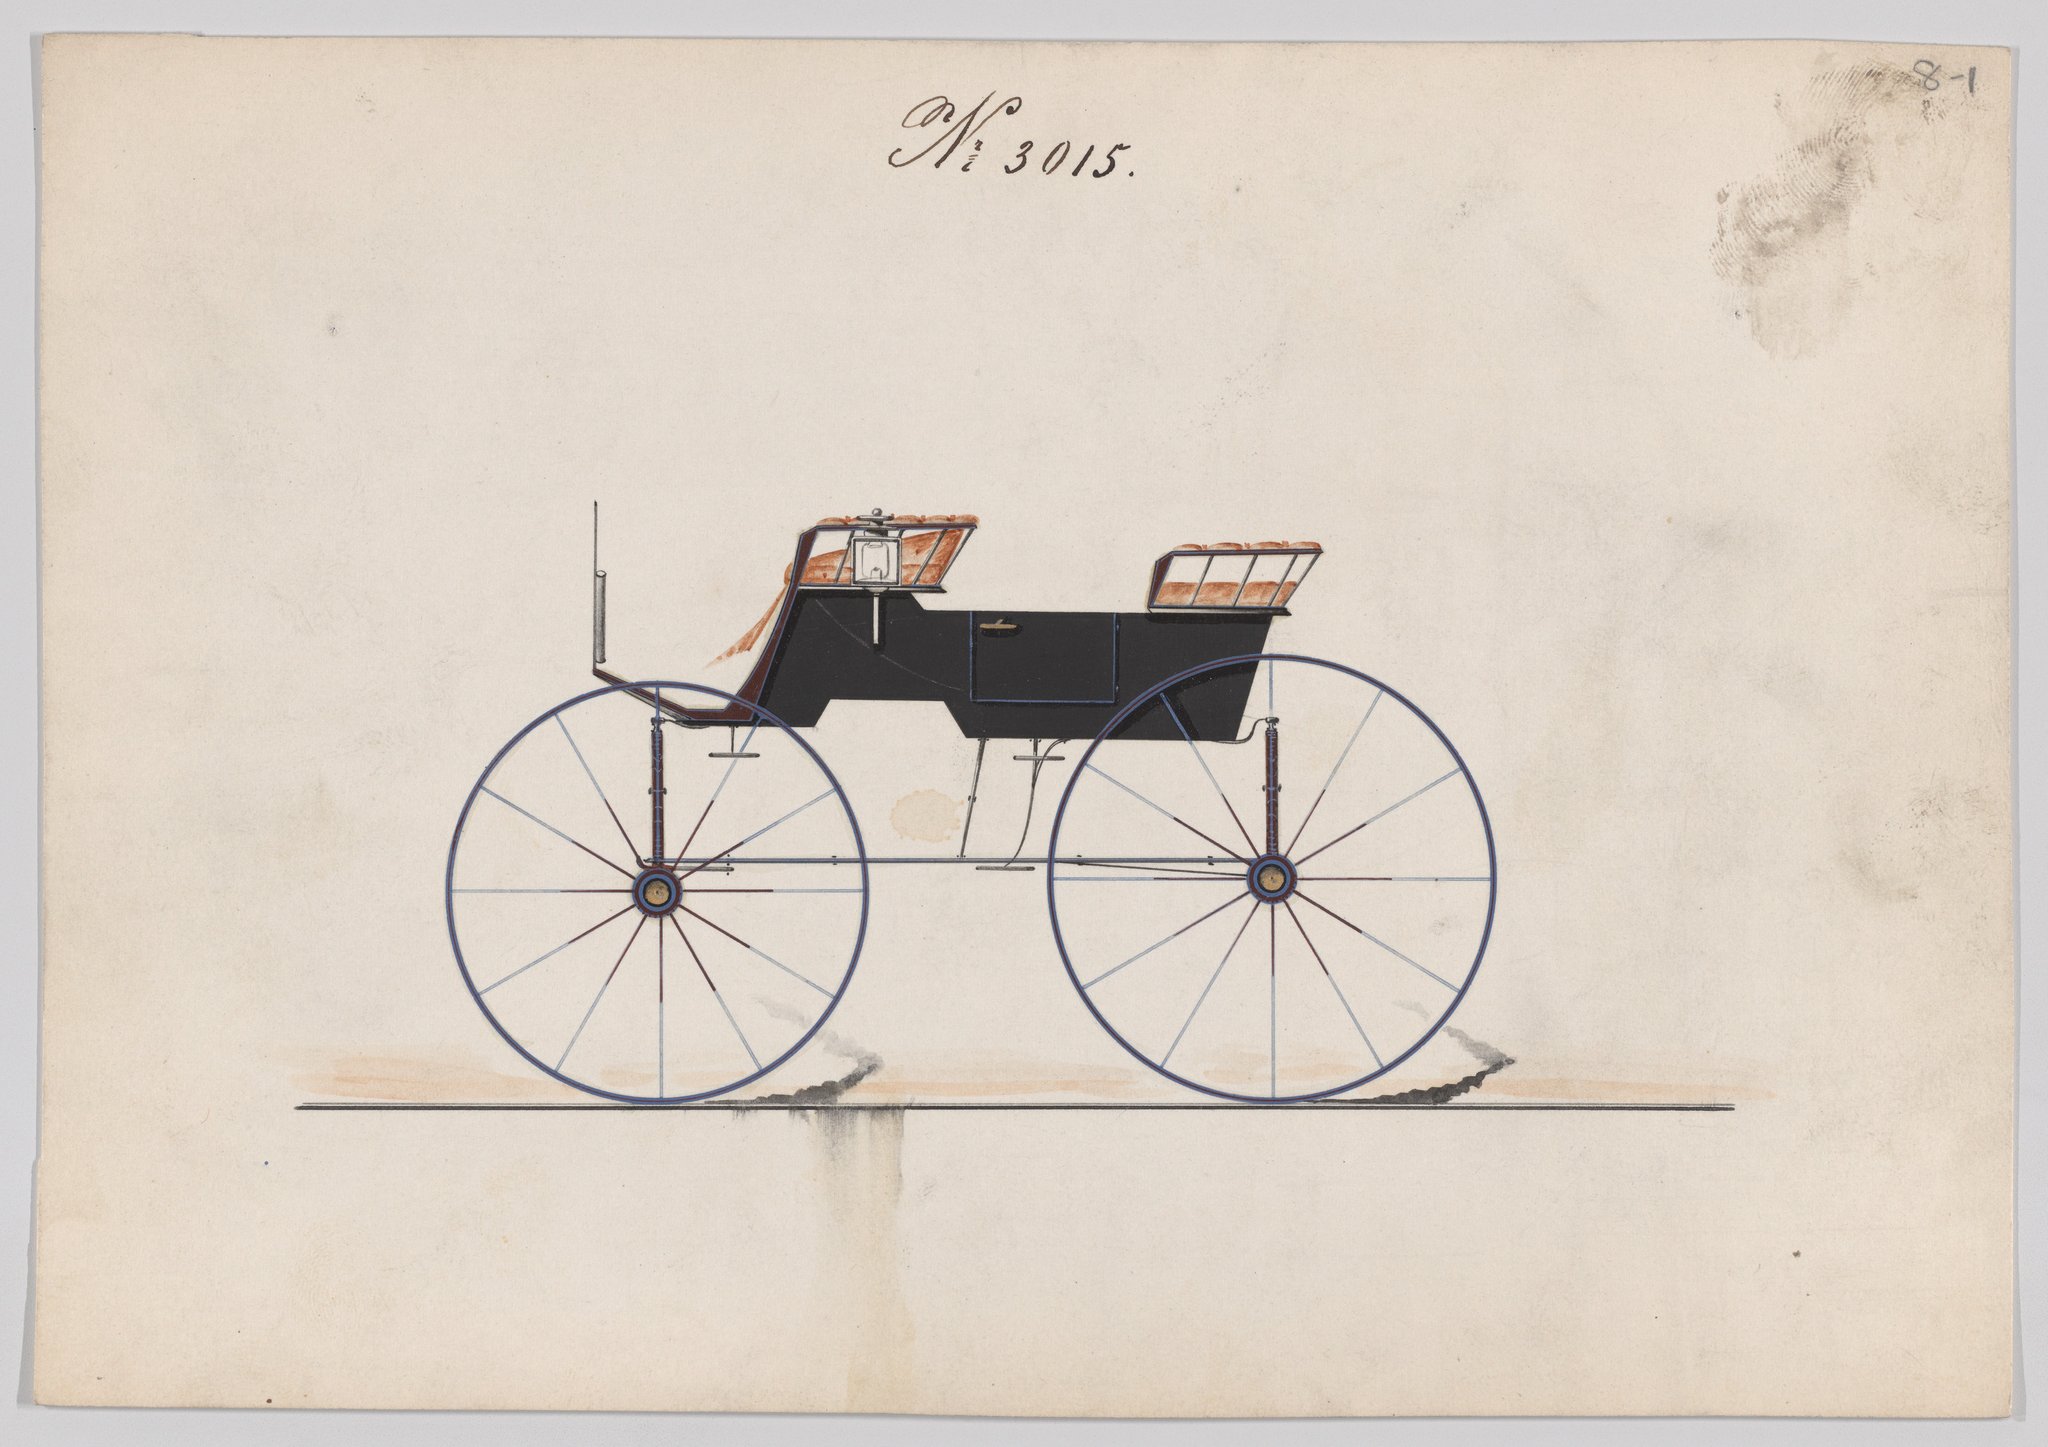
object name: drawing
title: Design for 4 seat Phaeton, no top, no. 3015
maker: brewster & co.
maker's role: manufacturer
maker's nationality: american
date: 1874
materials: gouache, ink, watercolor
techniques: pen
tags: carriages